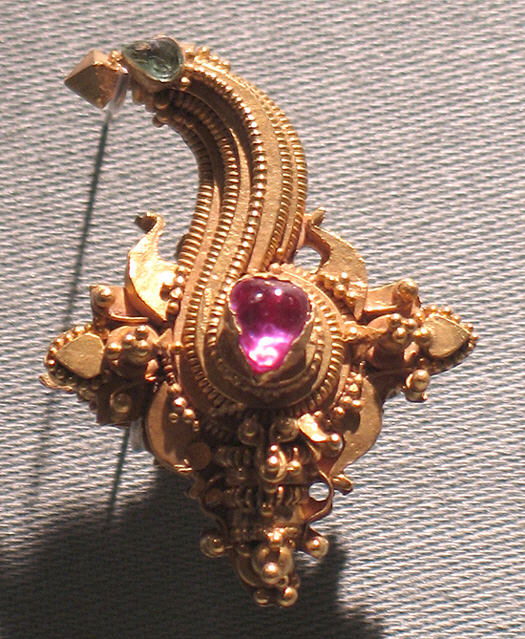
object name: earclip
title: Earclip with Conch Motif and Inlaid Stones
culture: indonesian, javanese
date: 801-1400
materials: gold, stone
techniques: inlay